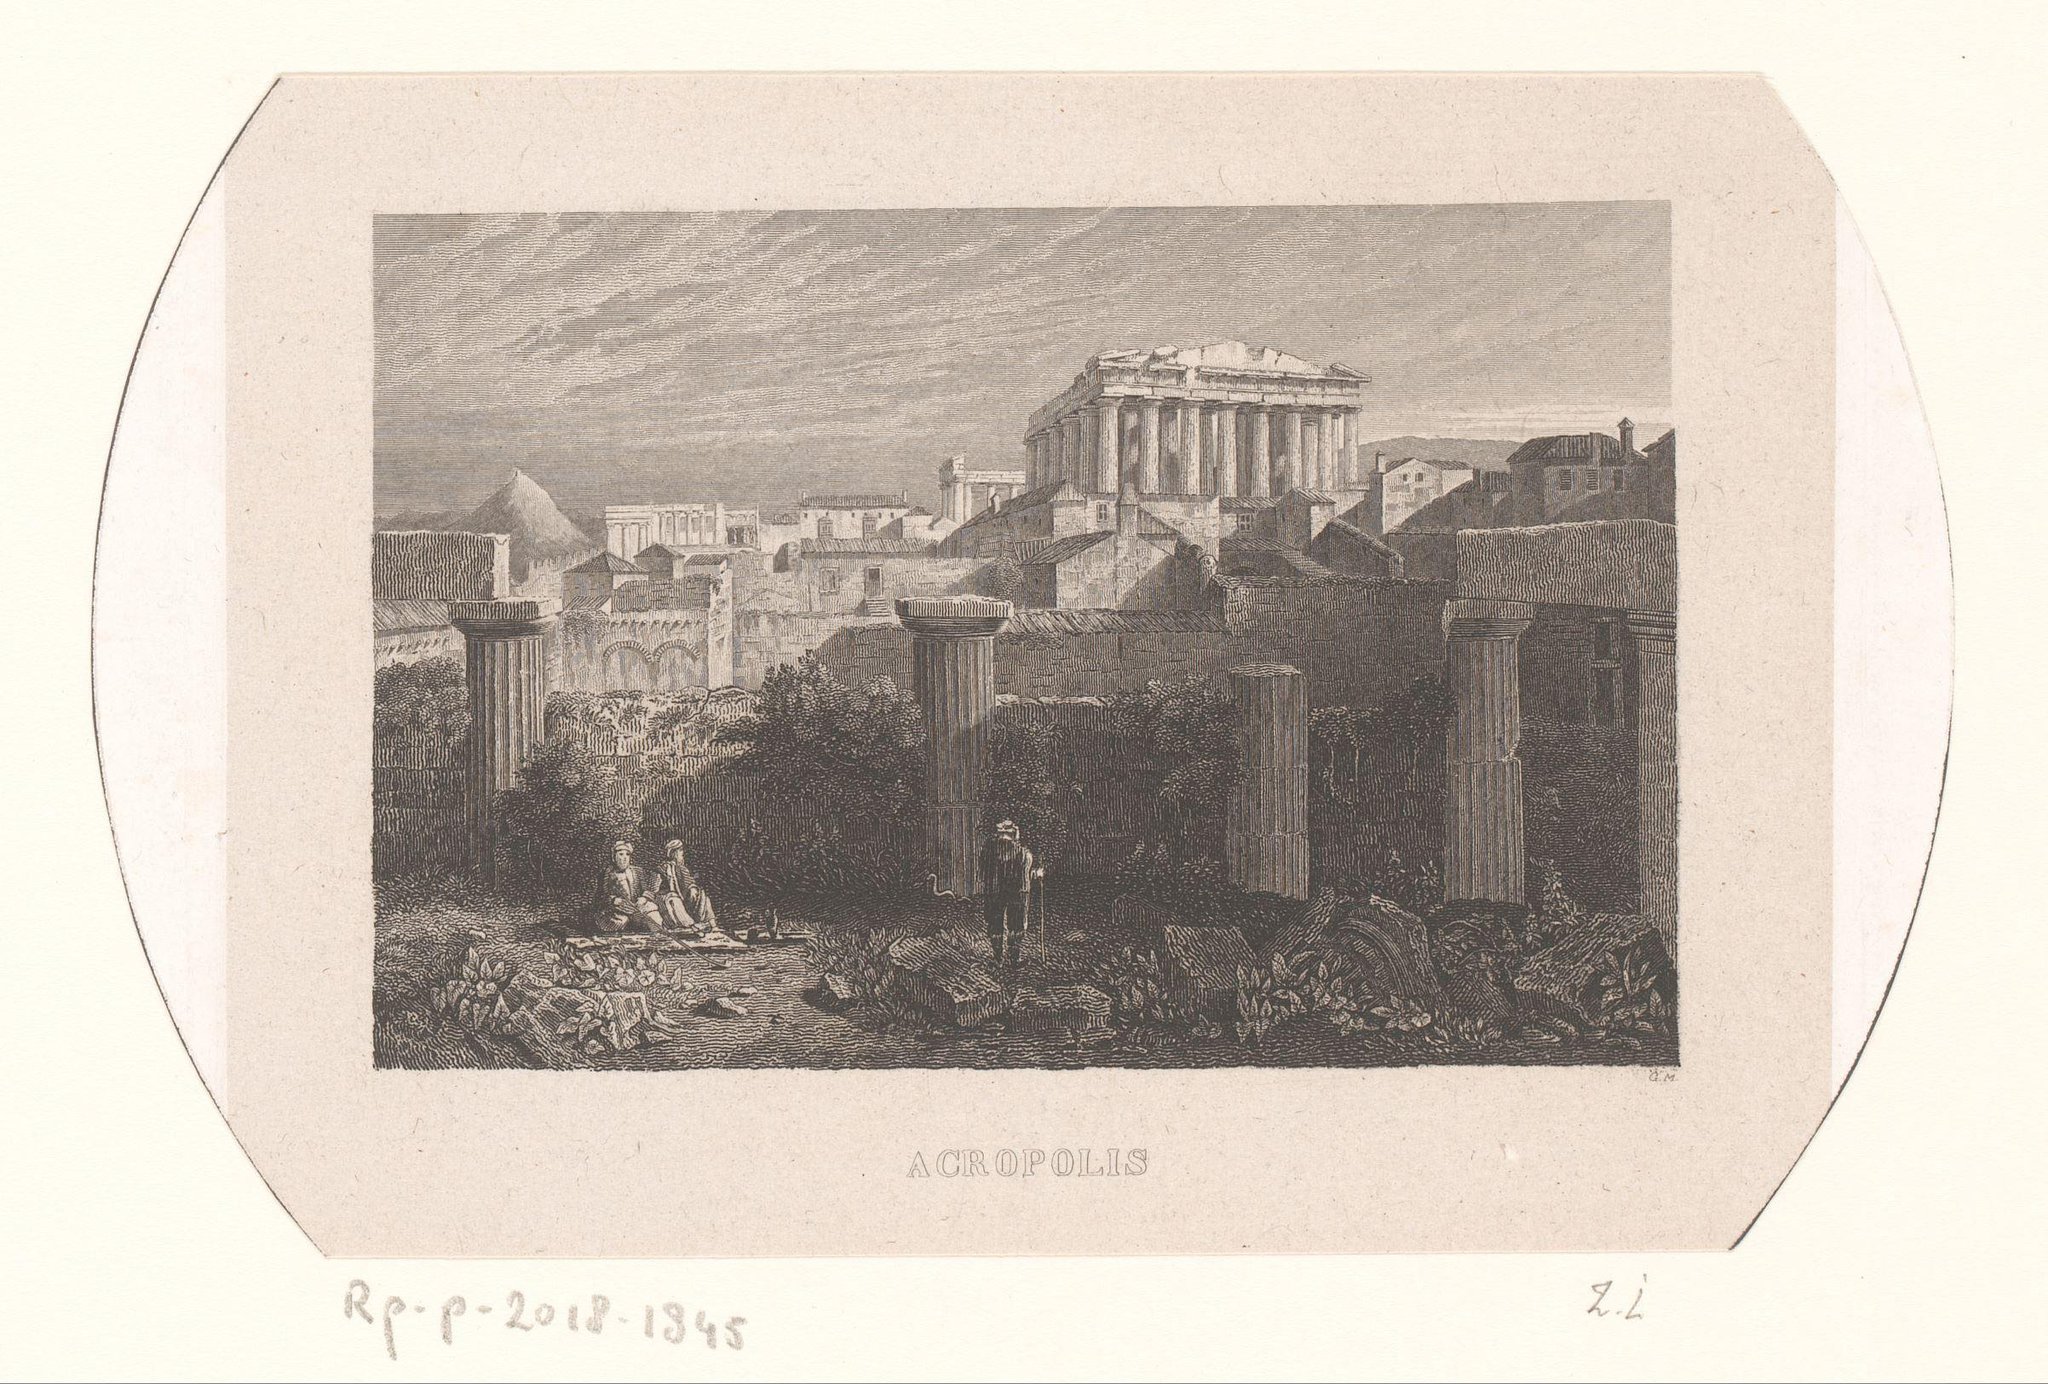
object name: print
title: Acropolis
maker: g.m.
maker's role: print maker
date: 1800-1899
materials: paper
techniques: etching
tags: prospect of city, town panorama, silhouette of city, temple, shrine ~ greek religion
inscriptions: collector's mark: Lugt 2228